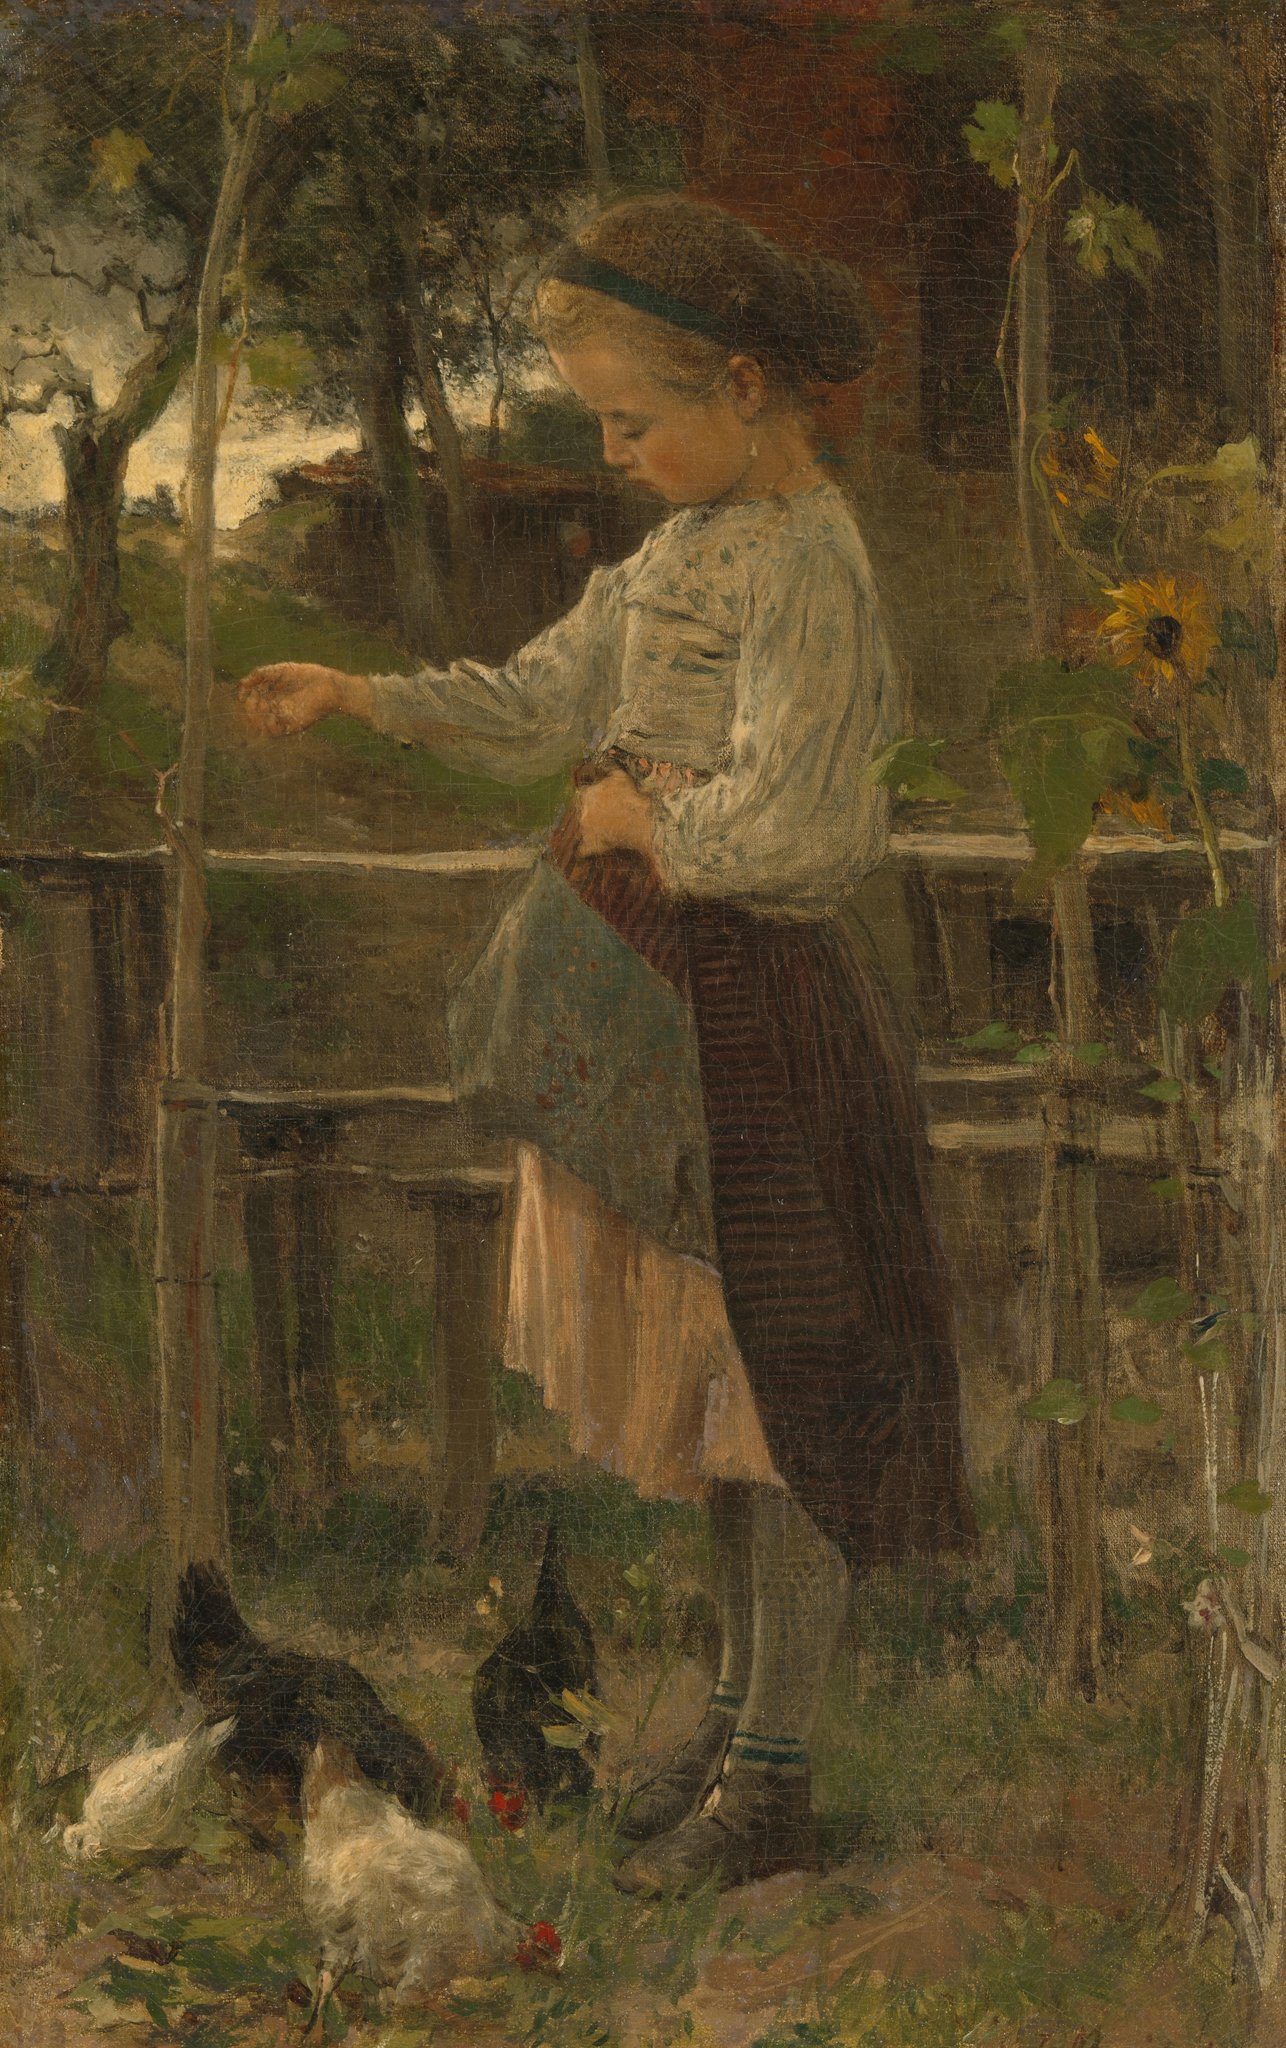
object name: painting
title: Feeding Chickens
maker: jacob maris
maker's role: draughtsman, painter, print maker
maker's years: 1837-1899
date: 1866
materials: canvas, oil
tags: fowl (cock, hen, chicken, etc.) (+ feeding animal), girl (child between toddler and youth)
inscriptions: signature and date: ‘J. Maris fc 1866’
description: Voorstelling getiteld 'Kippetjes voeren'. Een meisje is bezig in een tuintje de kippen te voeren, zij heeft de voorkant van haar rok omhoog gevouwen. Links en rechts zonnebloemen tegen een hek.